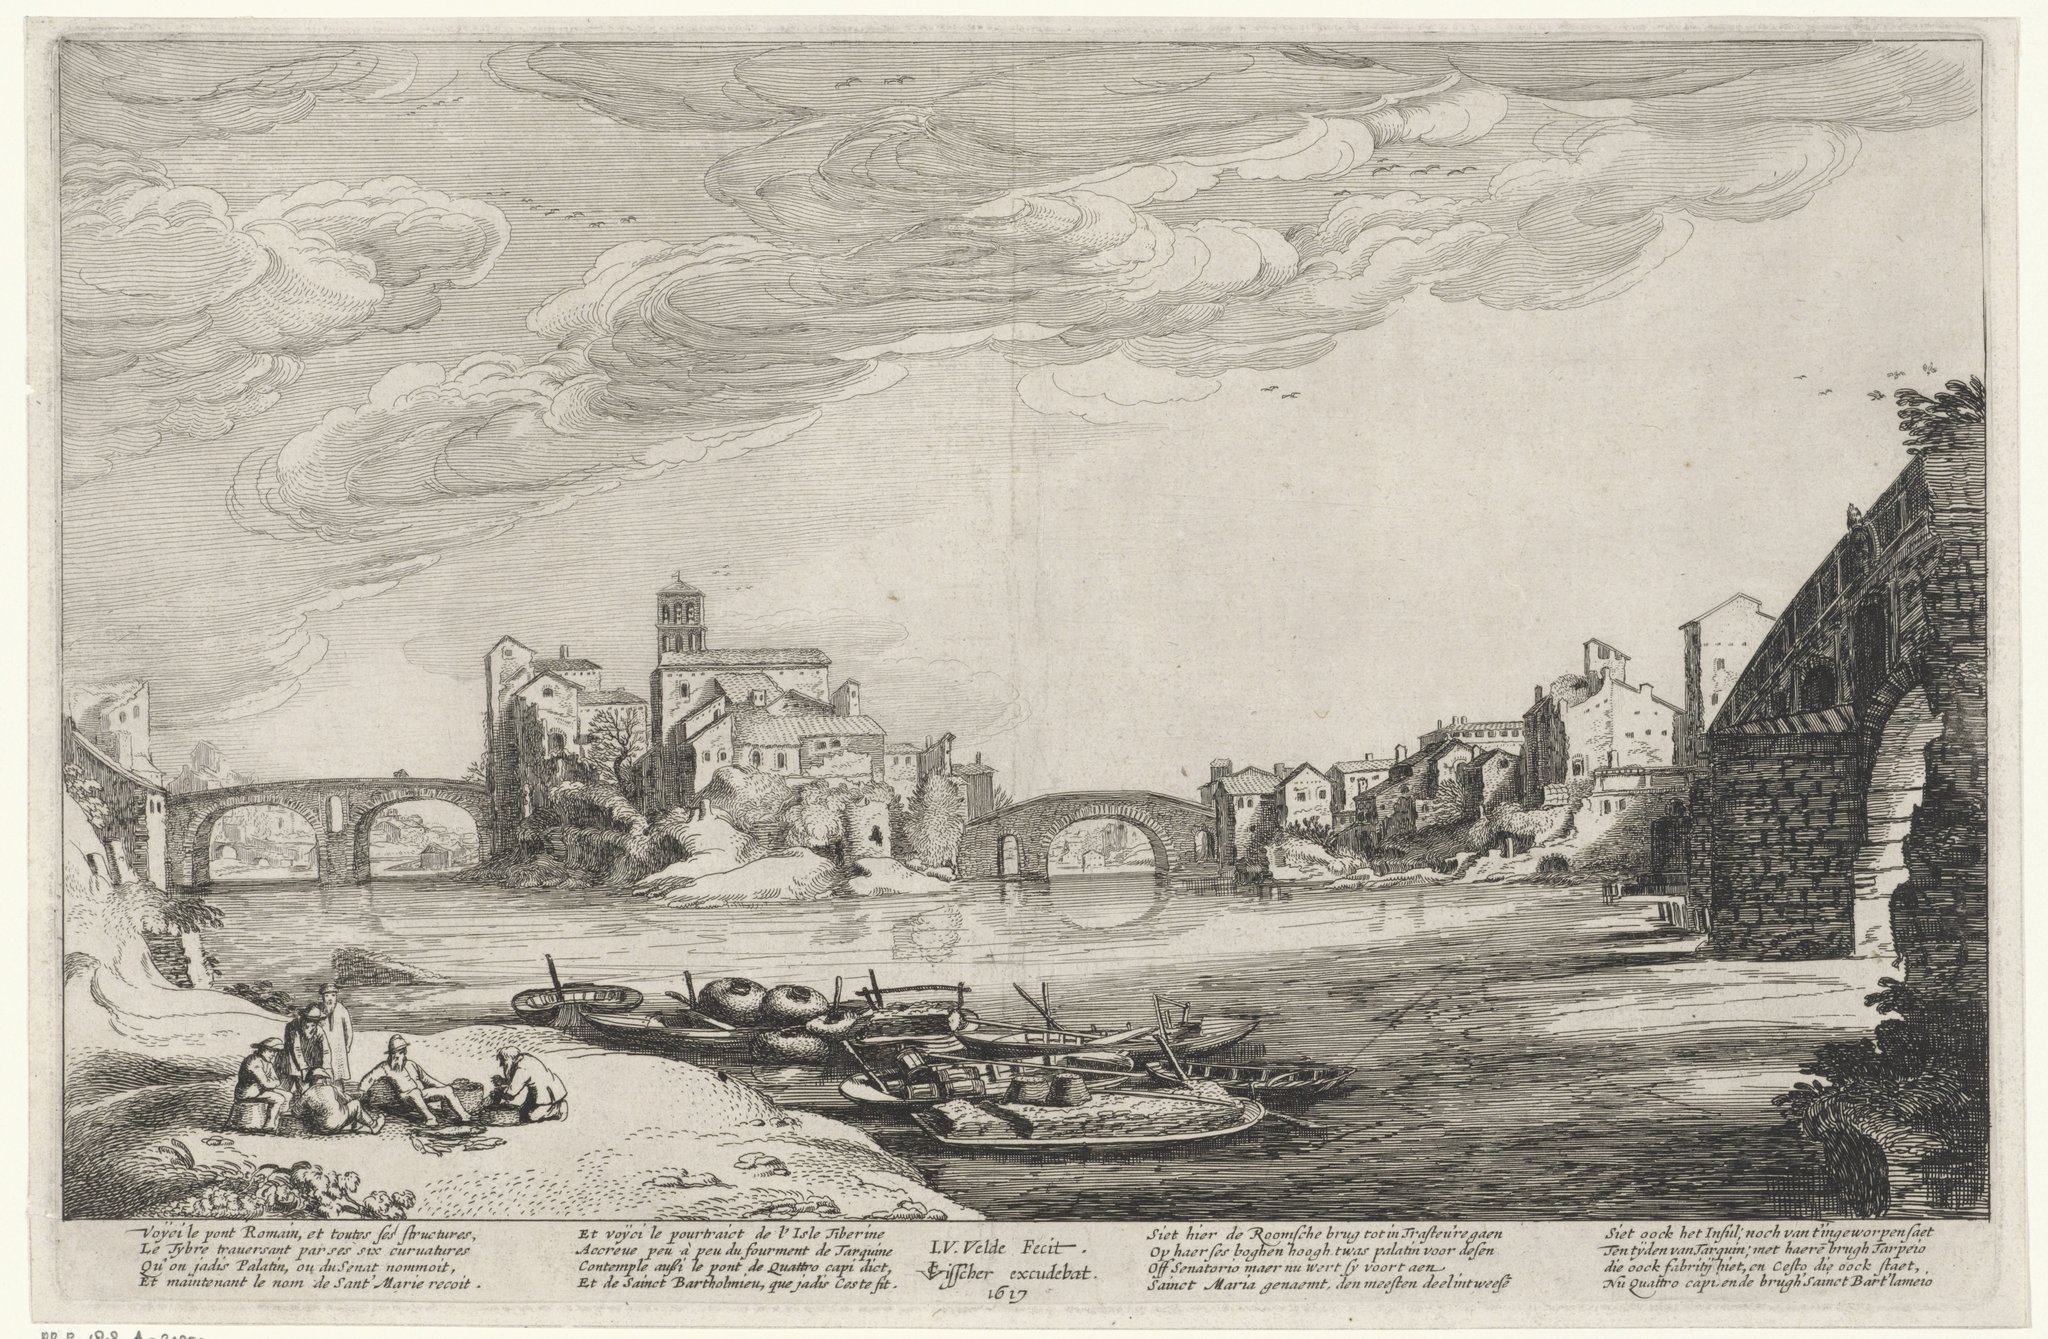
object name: print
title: Gezicht op de Tiber met Romeinse bruggen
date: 1617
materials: paper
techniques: etching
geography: amsterdam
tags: island, river, landscape with bridge, viaduct or aqueduct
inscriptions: collector's mark: Lugt 964, collector's mark: Lugt 1120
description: Gezicht op de rivier de Tiber bij Rome, met links de brug S. Maria en in het midden het Isola di S. Bartolomeo (Isola Tiberina). Links op de voorgrond een groep vissers.